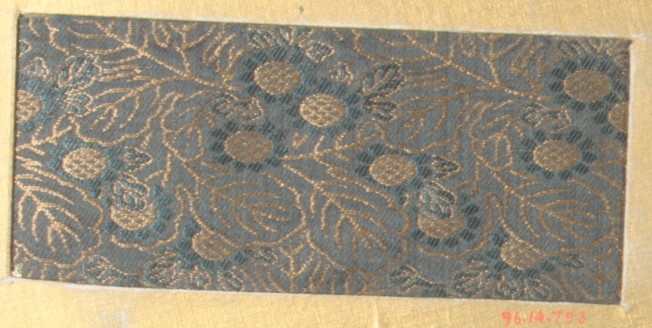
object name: piece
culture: japanese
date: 1701-1900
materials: silk